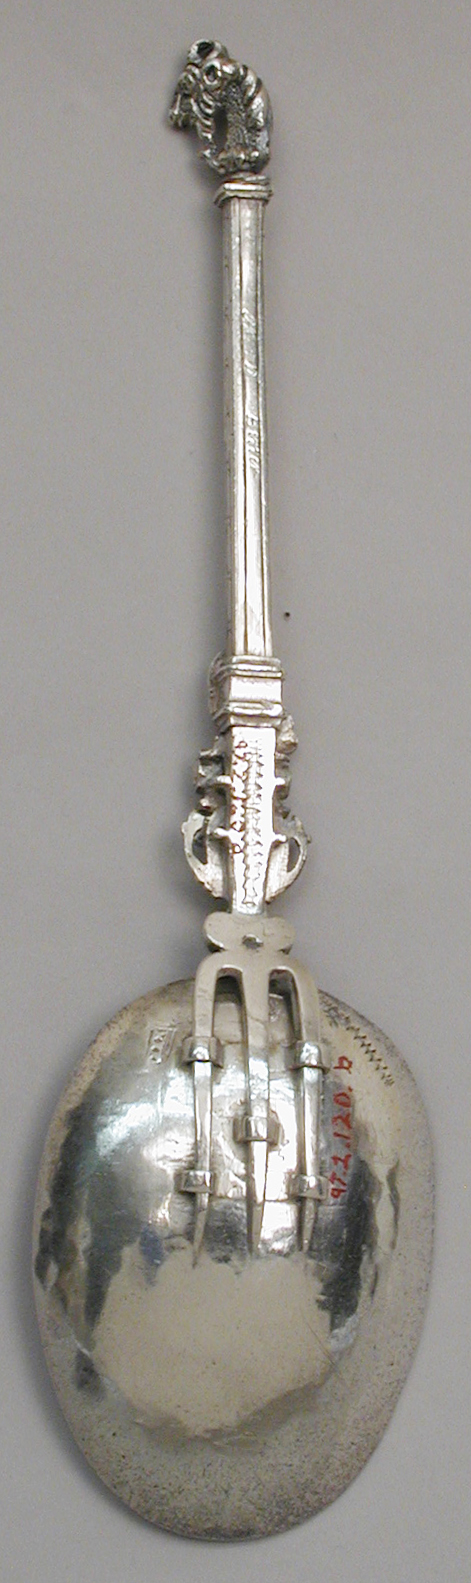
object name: spoon and fork combination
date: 1624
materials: silver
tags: human figures,dogs